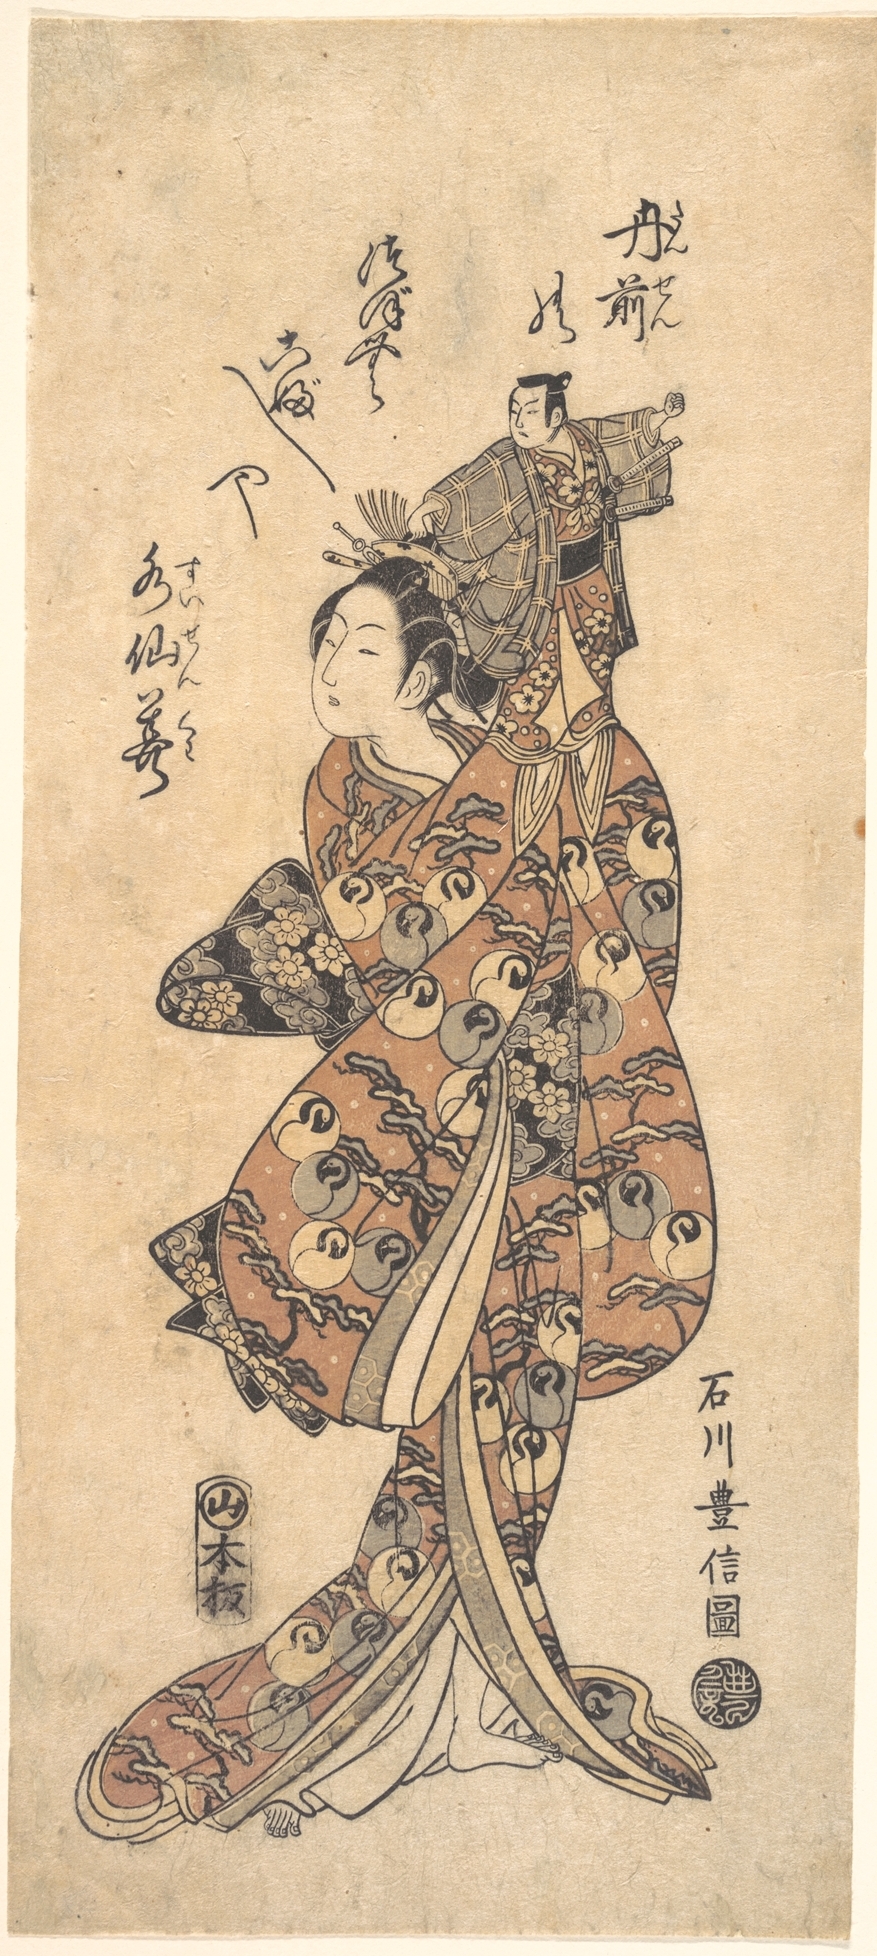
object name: print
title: The Actor Bandō Hikosaburo I in a Female Role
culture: japanese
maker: ishikawa toyonobu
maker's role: artist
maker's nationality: japanese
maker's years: 1711-1785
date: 1711-1785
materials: ink, paper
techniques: woodblock print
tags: women,dolls,actors